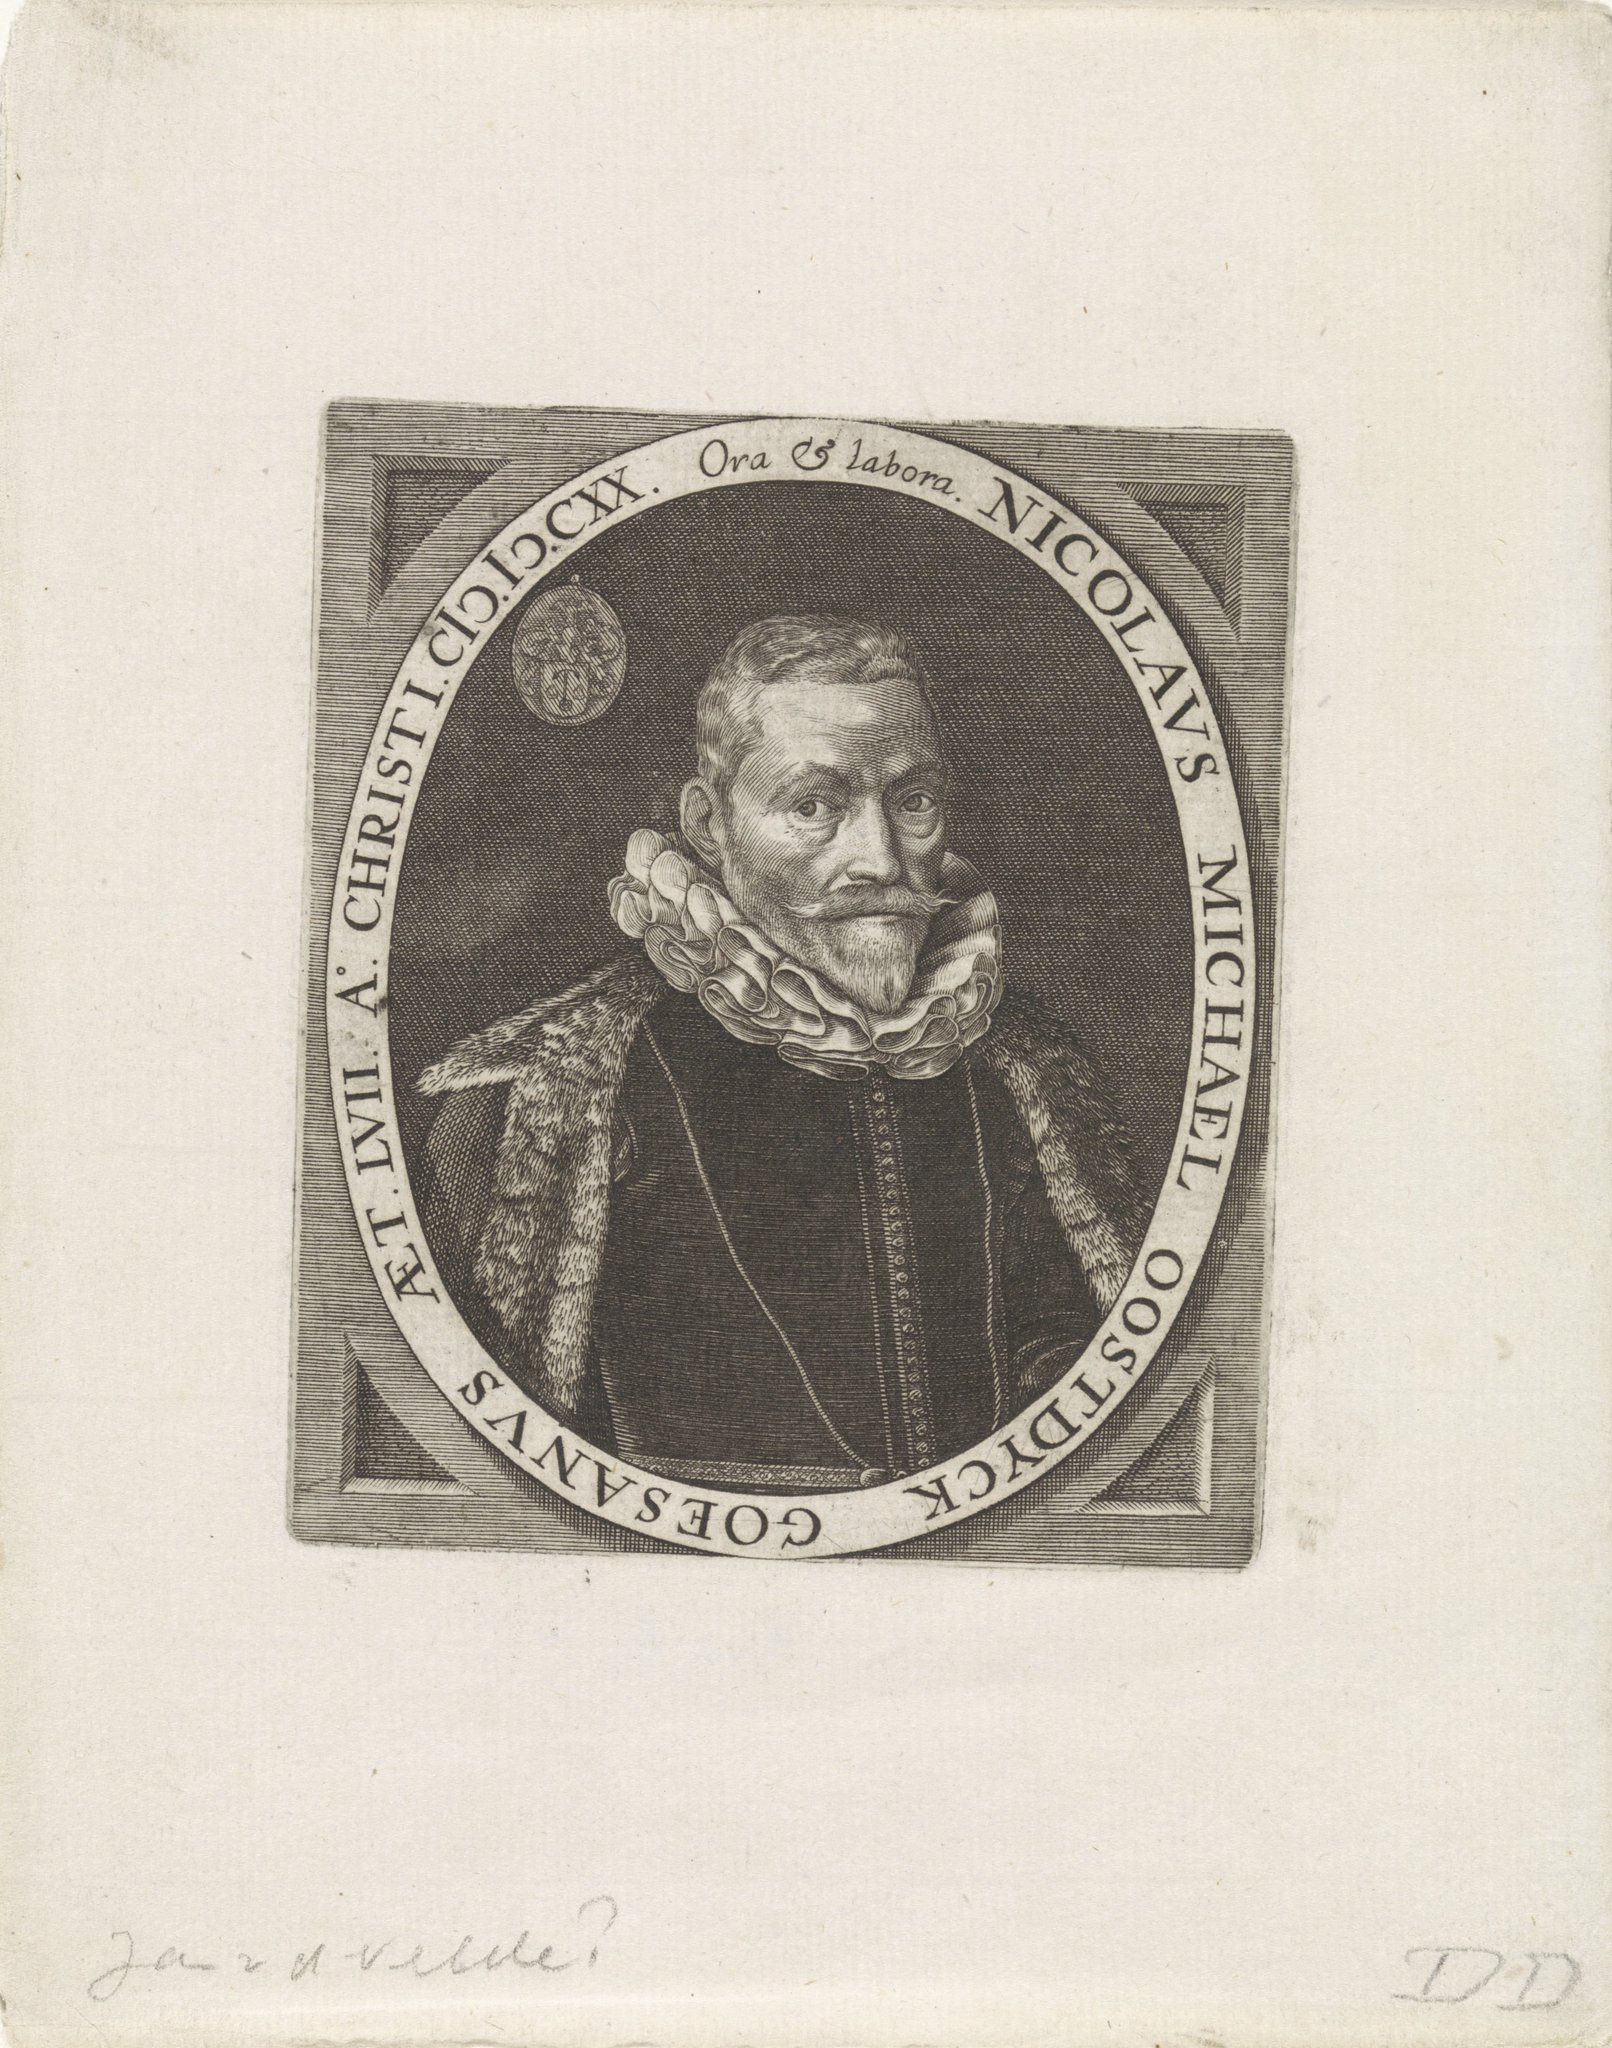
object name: print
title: Portret van Nicolaas Oostdyck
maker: de passe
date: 1620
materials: paper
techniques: engraving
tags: goes, schepen, rentmeester, nicolaas oostdijck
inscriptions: collector's mark: Lugt 2233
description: Portret van Nicolaas Oostdyck, schepen en stadsrentmeester te Goes, op 57-jarige leeftijd.